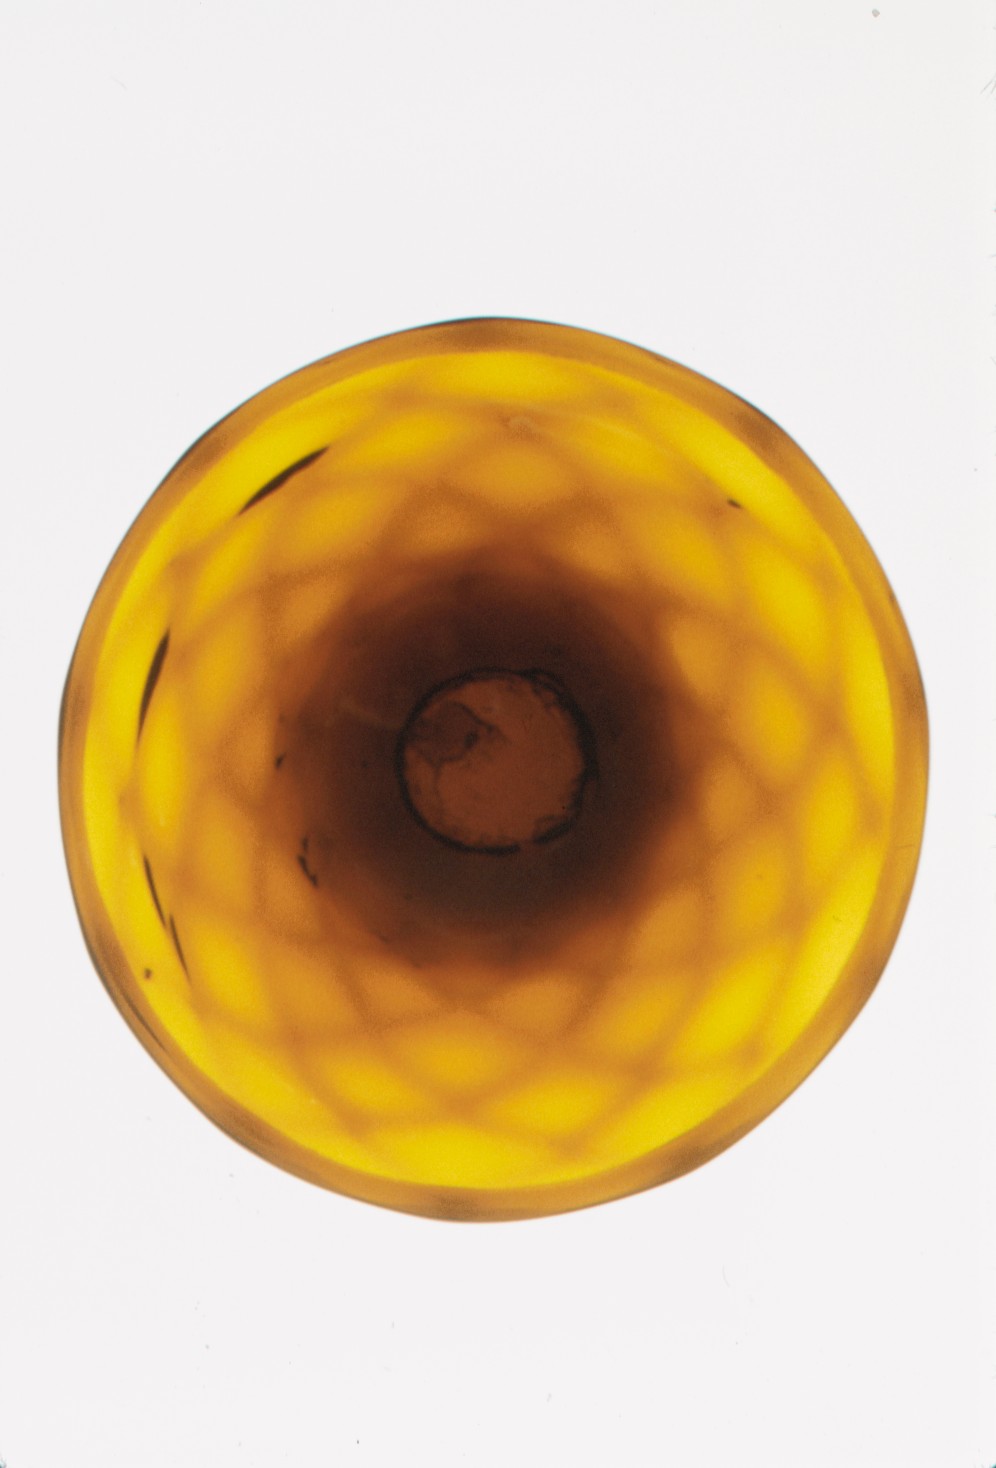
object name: pan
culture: american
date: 1800-1860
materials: amber, glass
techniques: glassblowing, molding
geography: united states